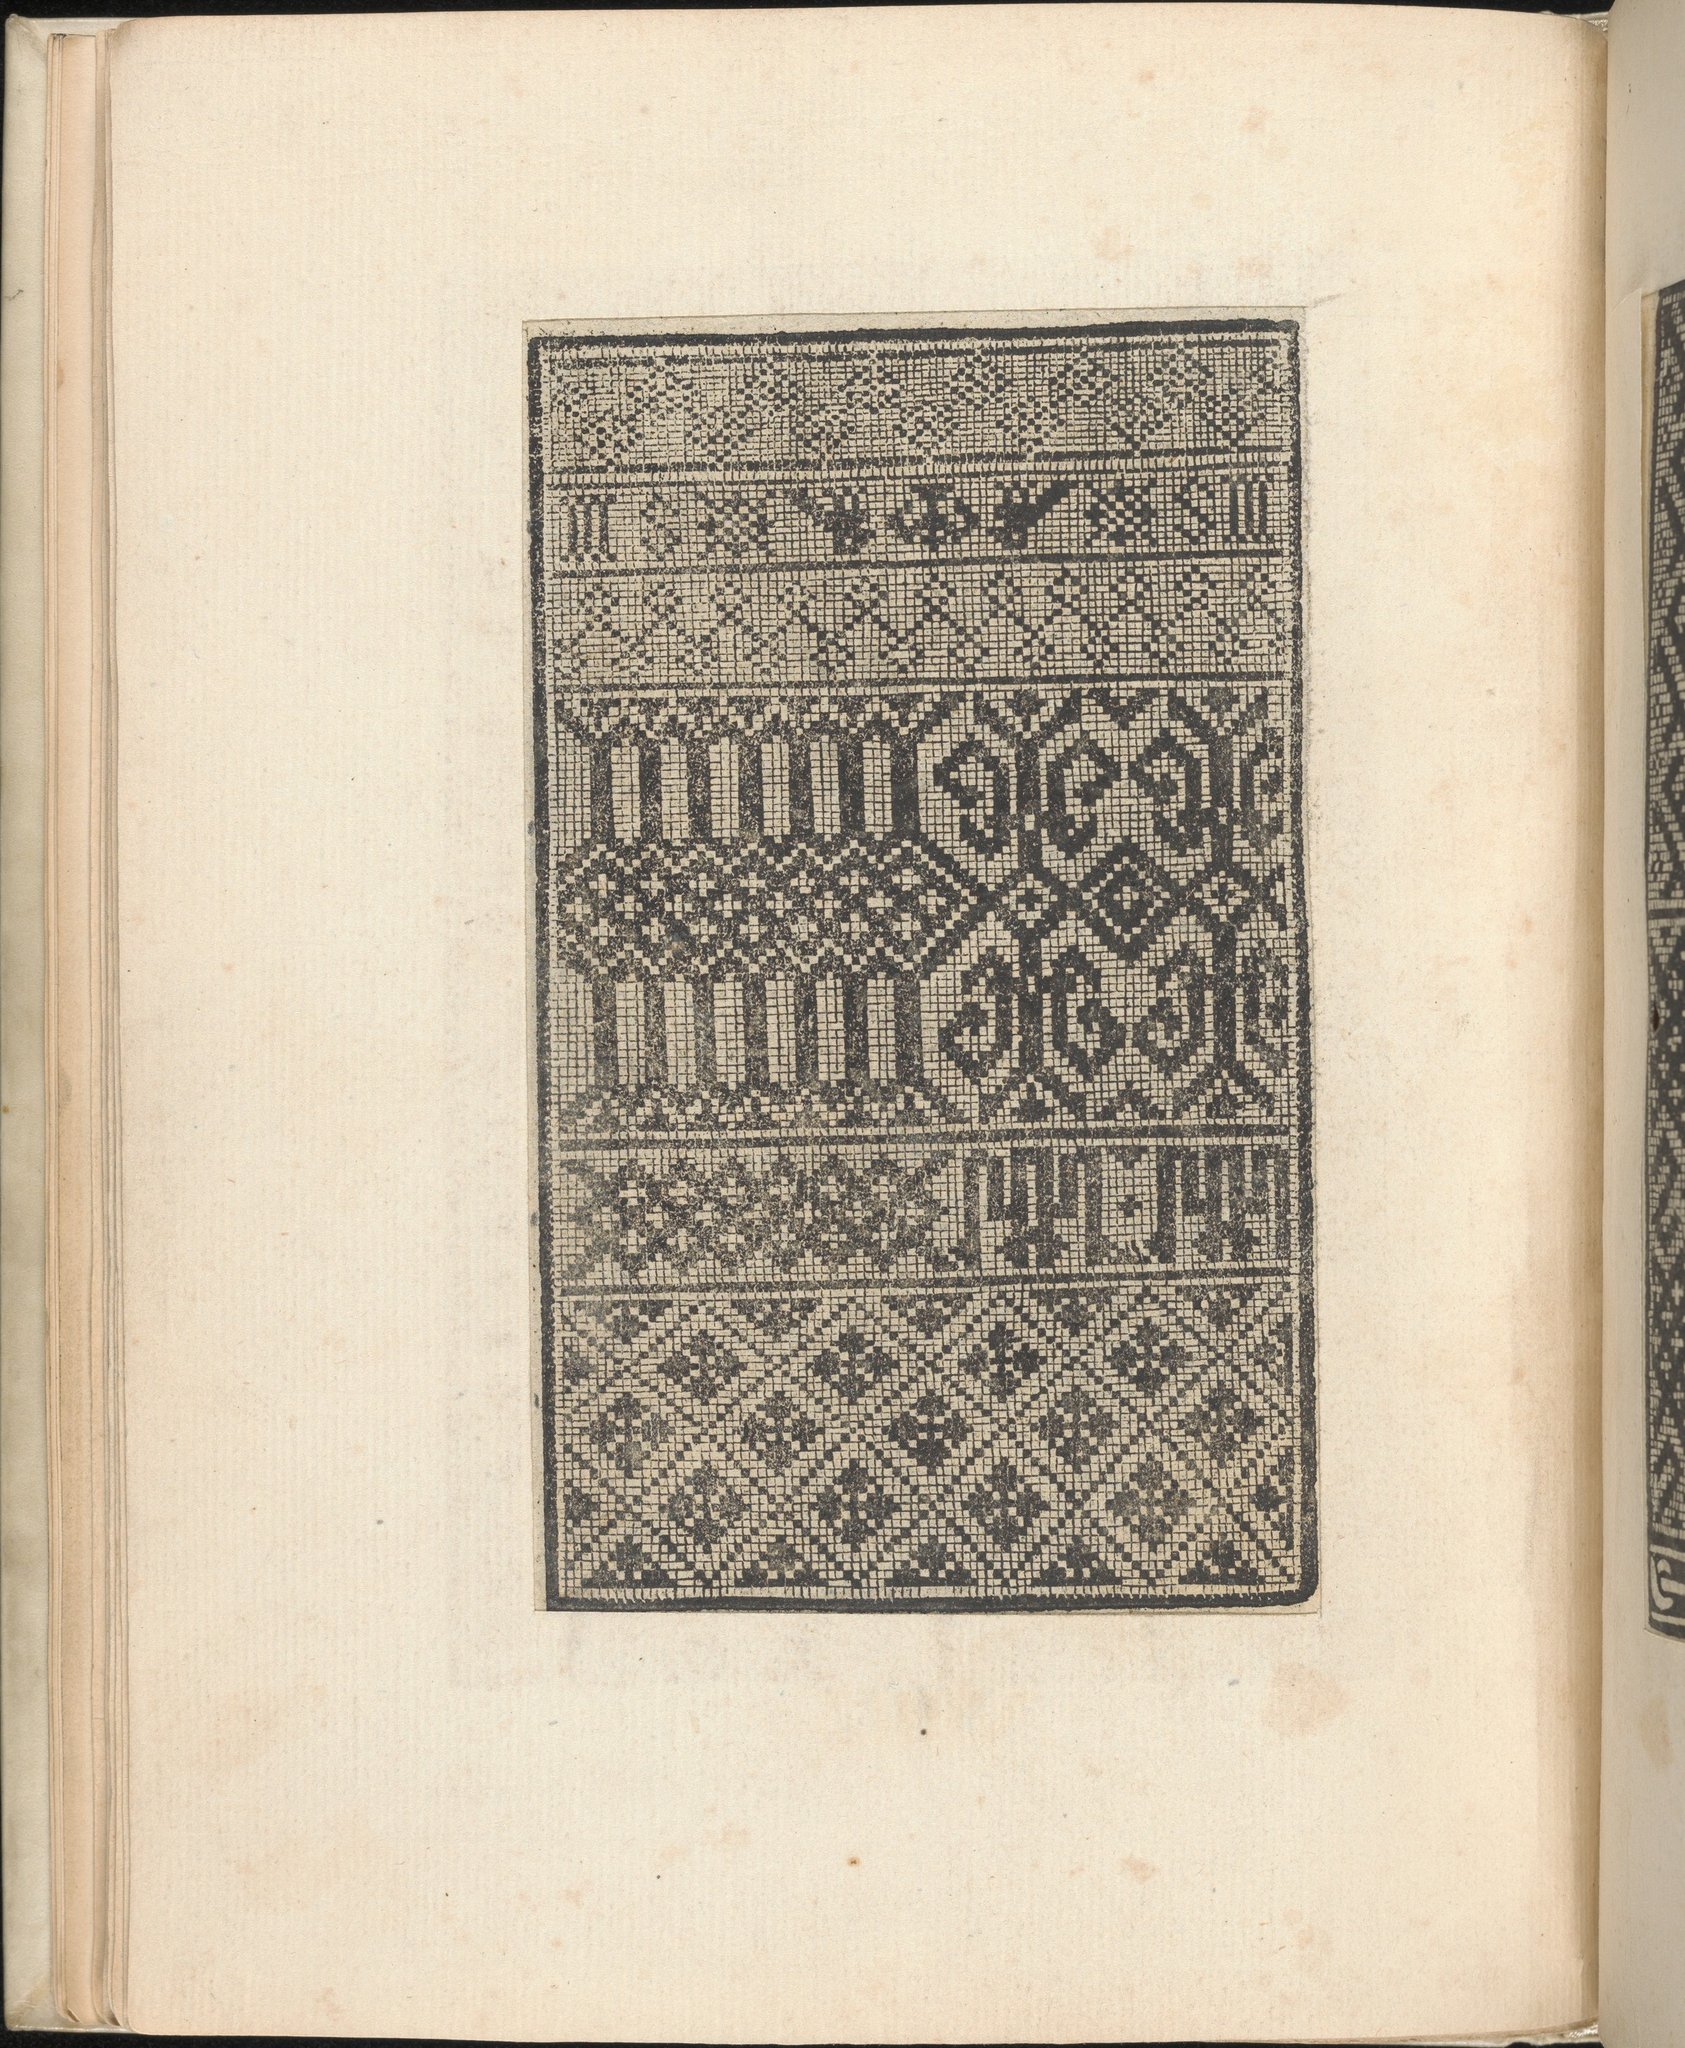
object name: book print ornament architecture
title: Esemplario di lavori, page 8 (verso)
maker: nicolò zoppino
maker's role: publisher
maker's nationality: italian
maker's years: 1478-1544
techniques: bookbinding, inlay, woodcut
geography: italy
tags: ornament